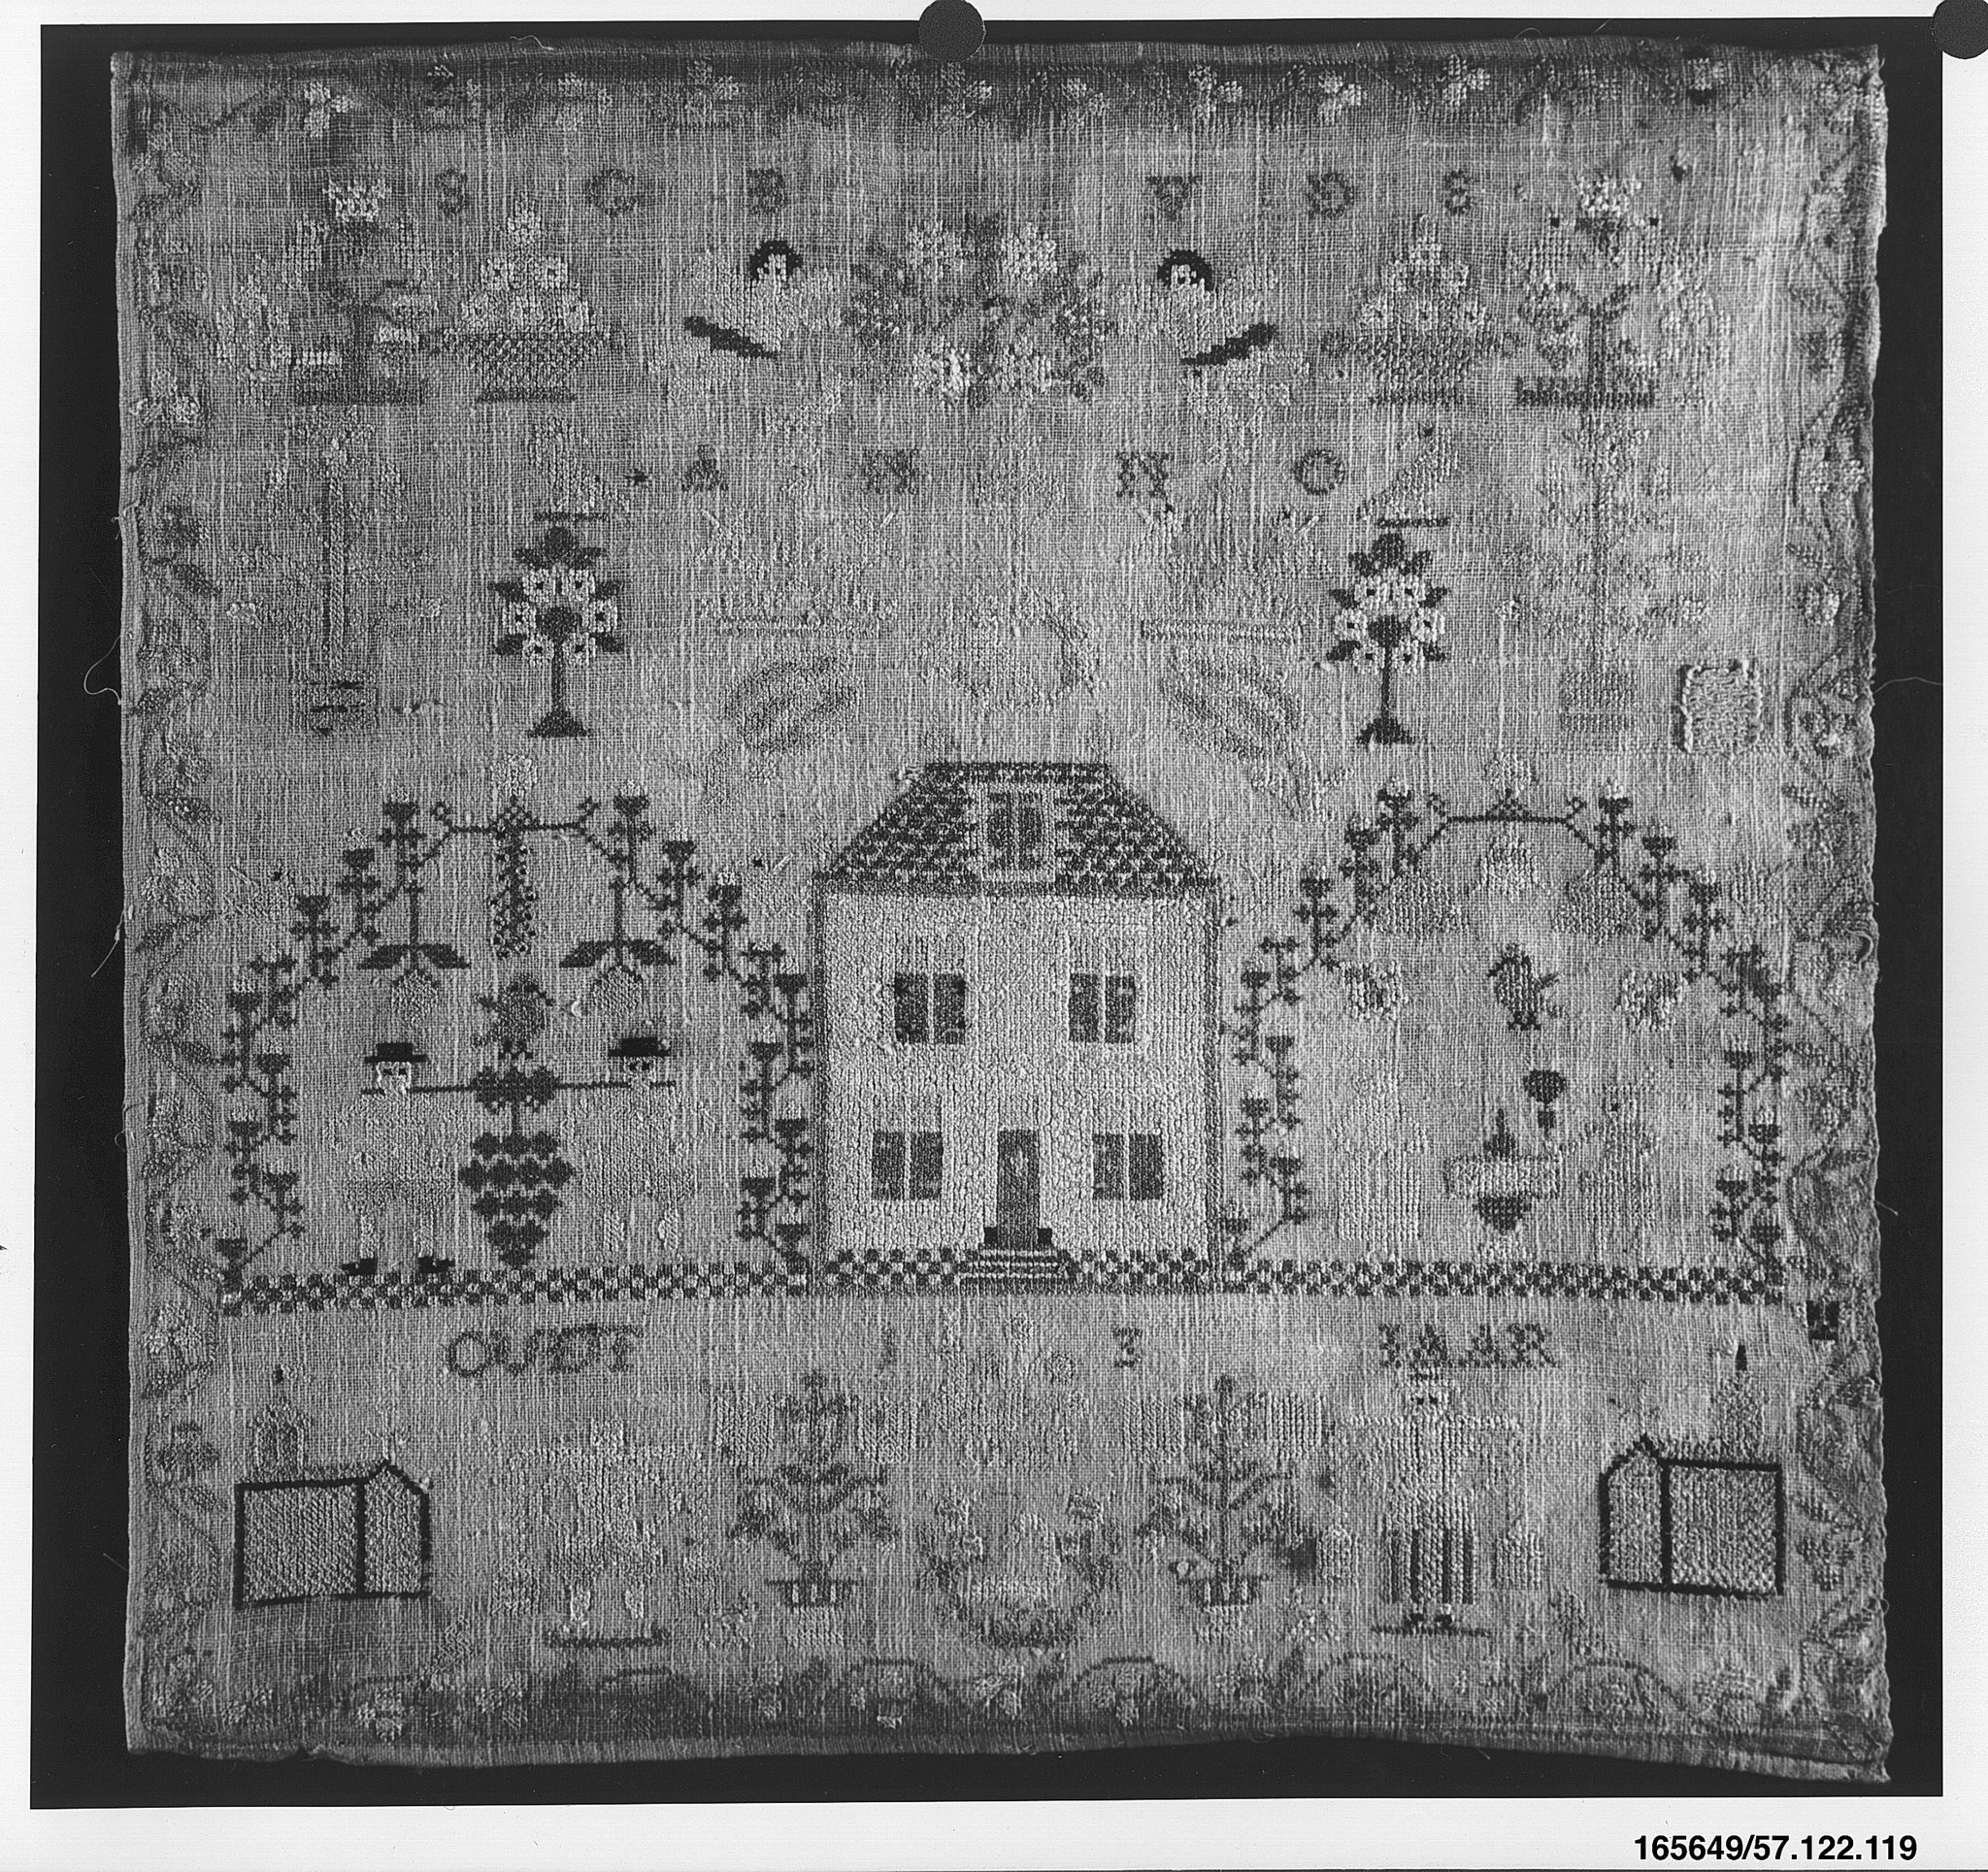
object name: sampler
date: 1779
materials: cotton, silk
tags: houses,flowers